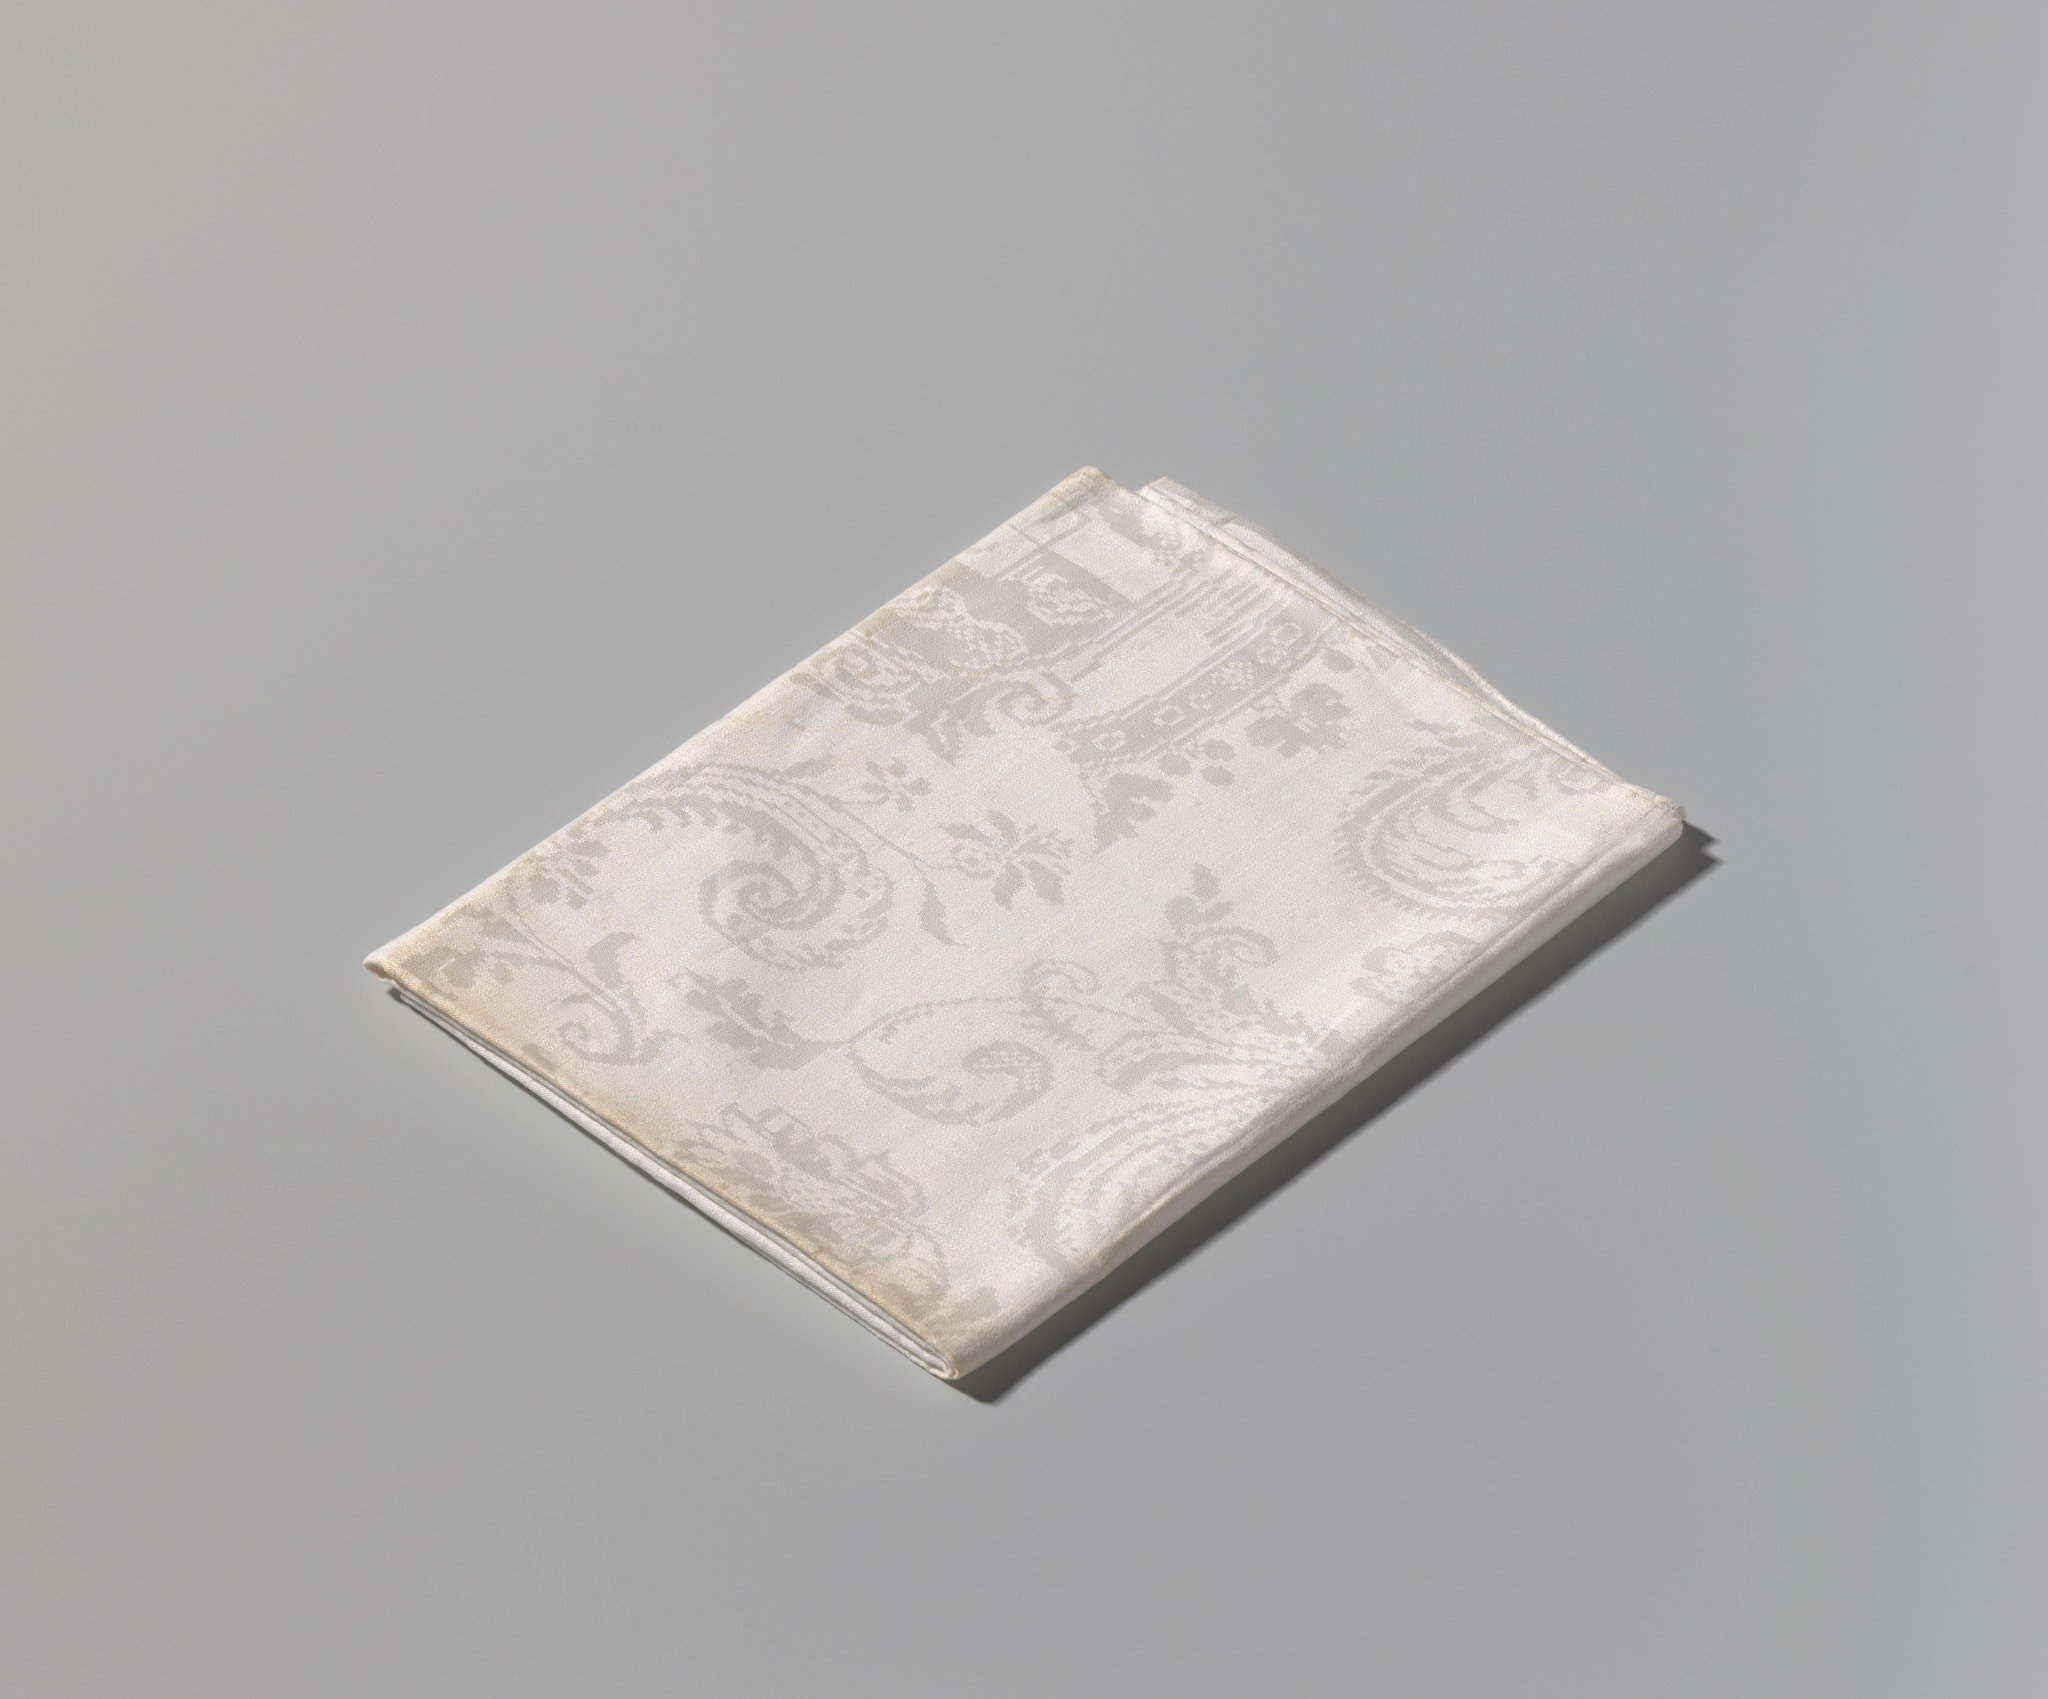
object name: napkin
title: Servet met het wapen van Cornelis Hop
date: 1700-1724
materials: linen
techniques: damask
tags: cornelis hop (ii)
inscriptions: mark: ‘H’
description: Servet van linnendamast met het wapen van Cornelis Hop. Middenveld: symmetrische patroon van veelsoortige voluutranken met op de knooppunten geblokte verdikkingen. Daartussen een liggend ovaal schild met een wapen van Cornelis Hop (1685-1762), ambassadeur aan het hof van koning Lodewijk XV van Frankrijk: gevierendeeld, 1 en 4 kopvogel staande op bol (de vogel van 1 omgewend, die van 4 omziend); 2 en drie twee afgewende vleugels. Hartschild gedeeld: 1 een dwarsbalk, 2 rechts een vijfpuntige ster, links een gewende wassenaar. Het schild gedekt met vijfbladerige kroon. Schildhouders: rechts een afgewende adelaar, links een afgewende leeuw. Randen: wapentrofeeën. Hoeken: een rondas. Rondom blokkenrand.